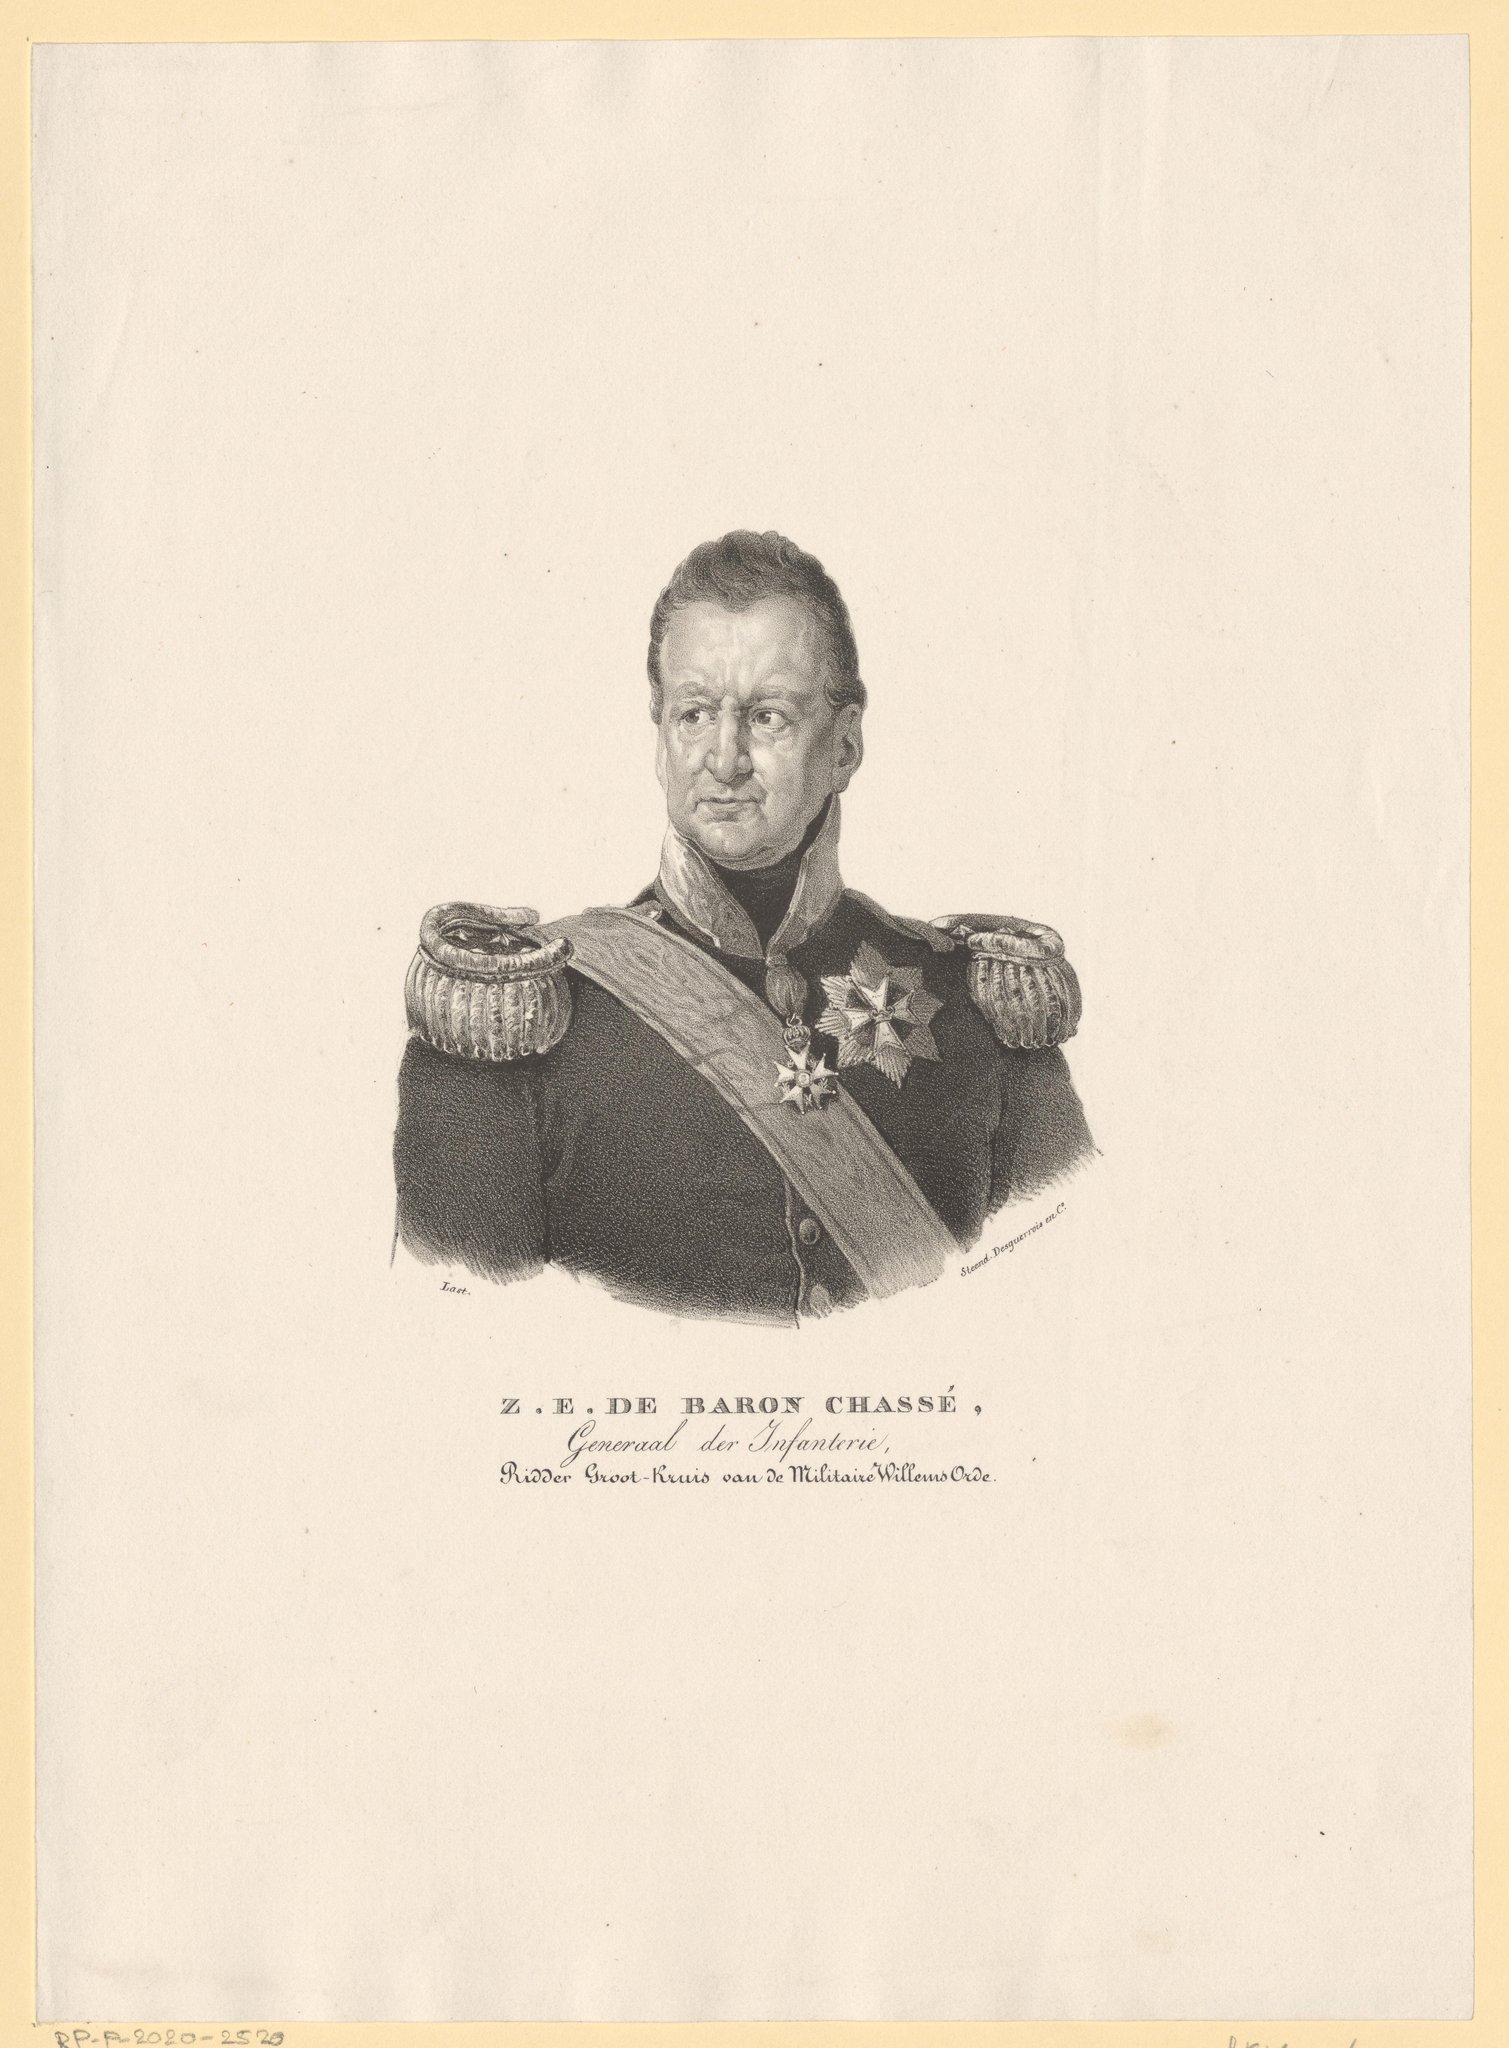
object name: print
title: Portret van David Hendrik baron Chassé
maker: carel christiaan antony last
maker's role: print maker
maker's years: 1808-1876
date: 1827-1900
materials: paper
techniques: lithograph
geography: amsterdam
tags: david hendrik baron chassé, commander-in-chief, general, marshal, historical persons